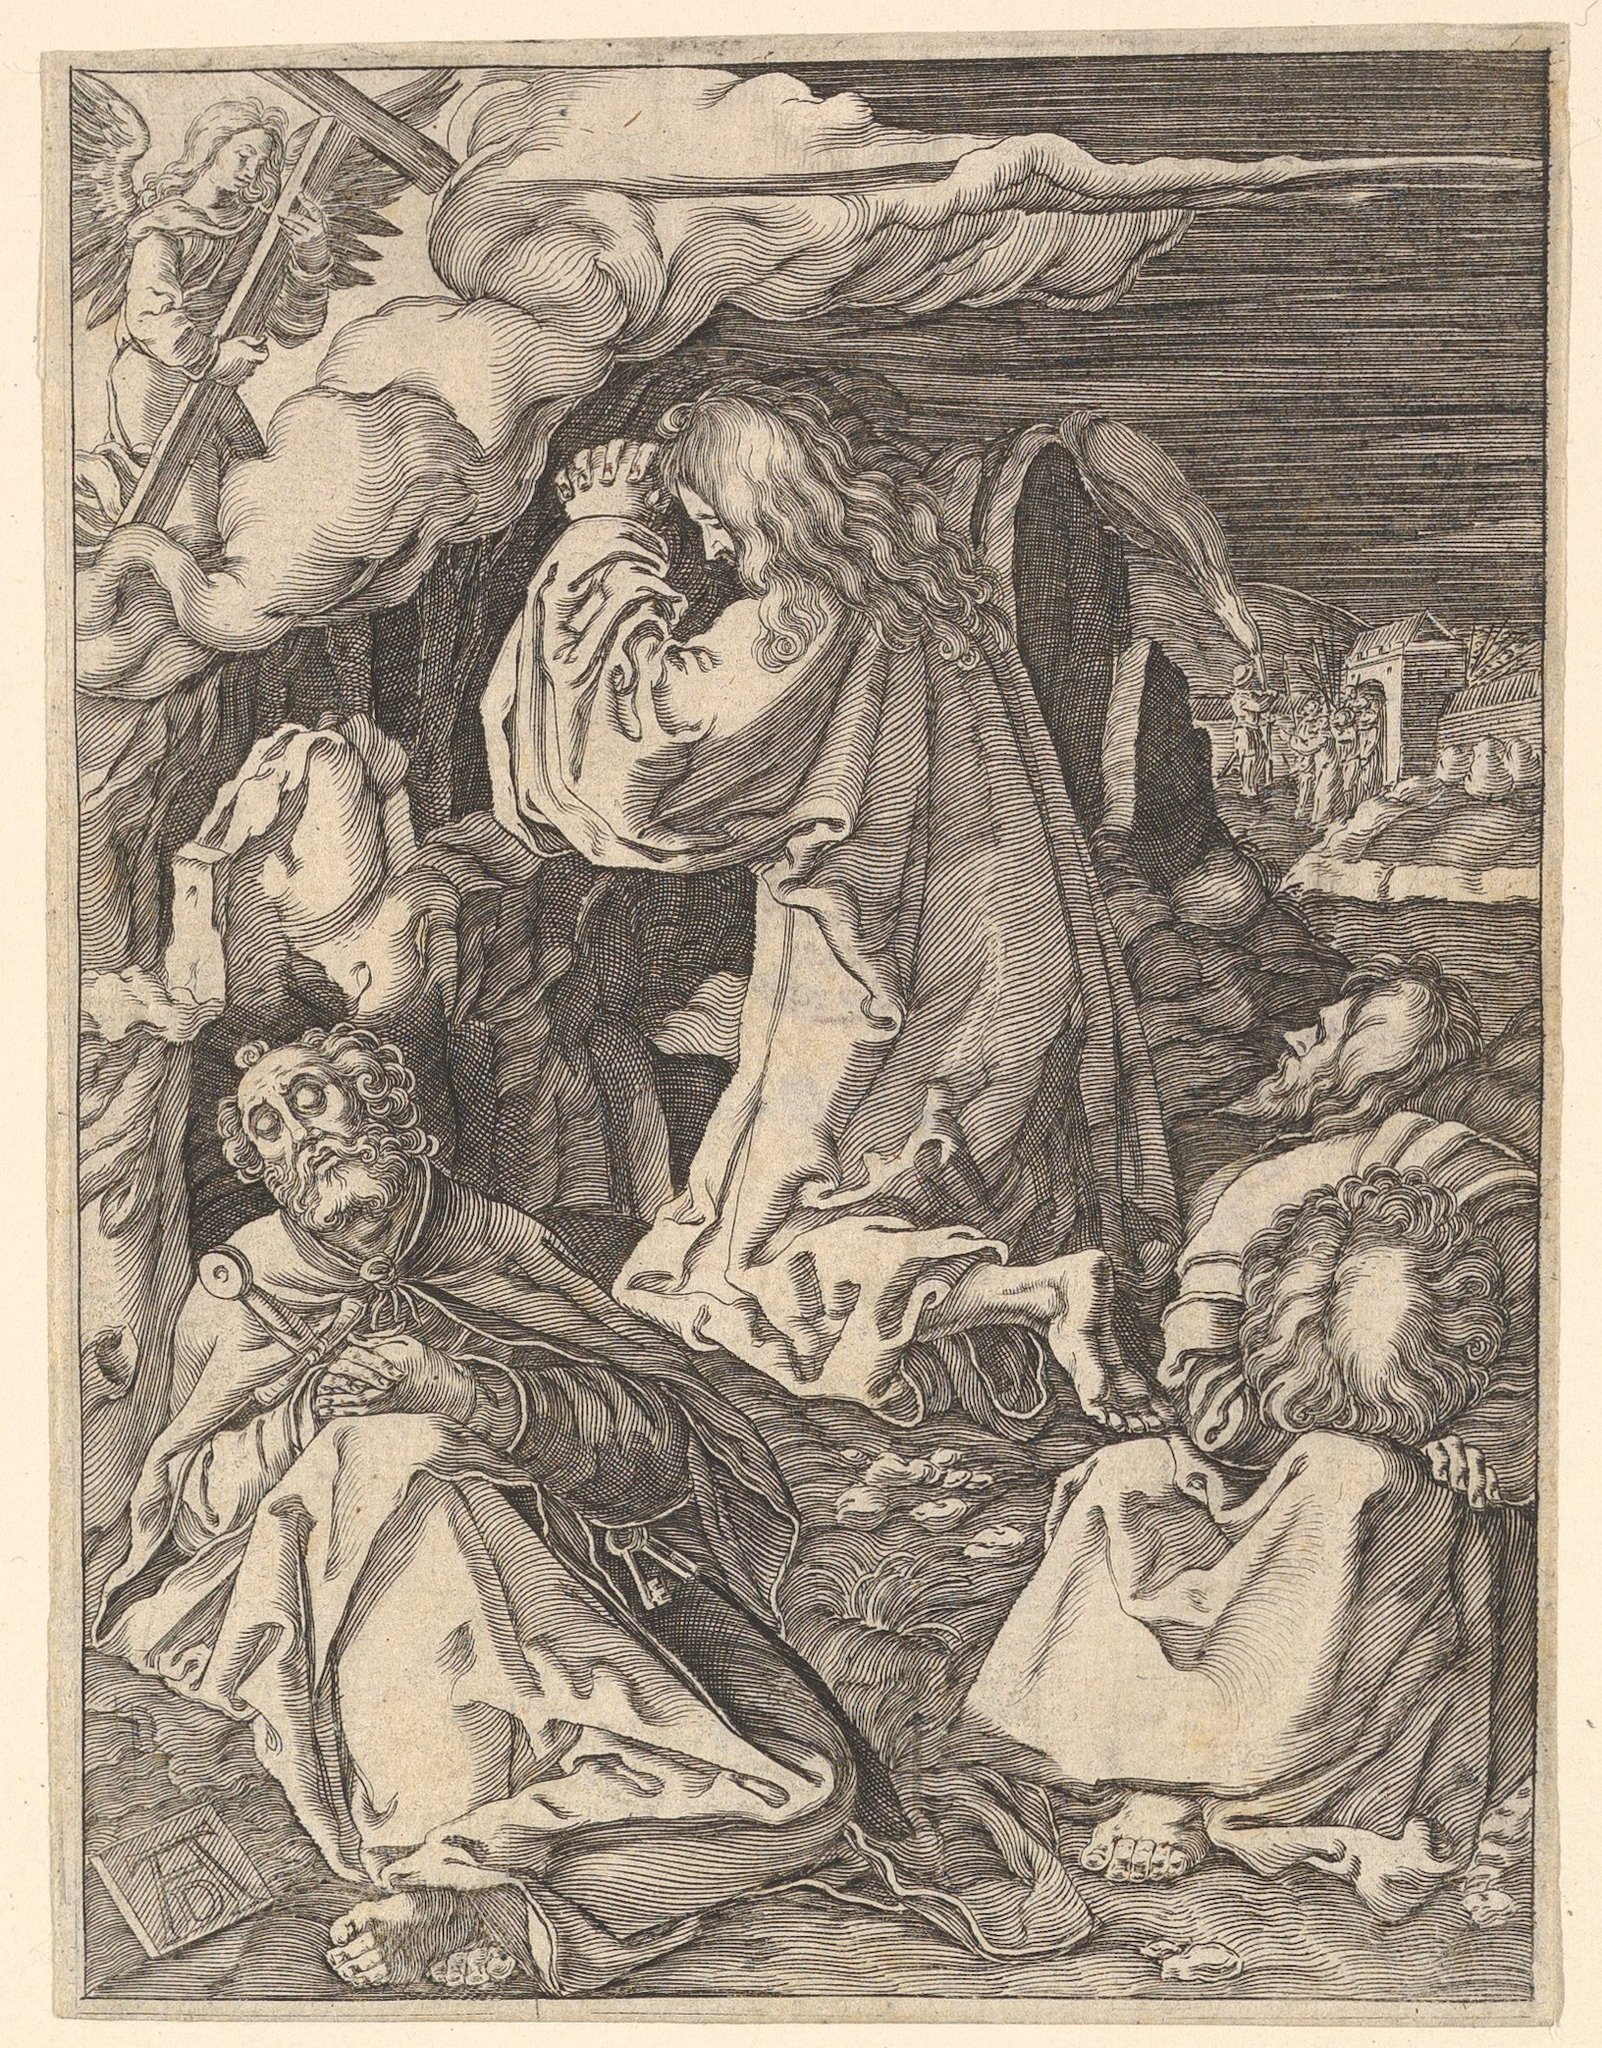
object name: print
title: Engraved copies of The Little Passion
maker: albrecht dürer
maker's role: artist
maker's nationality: german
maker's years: 1471-1528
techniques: engraving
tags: men,angels,jesus